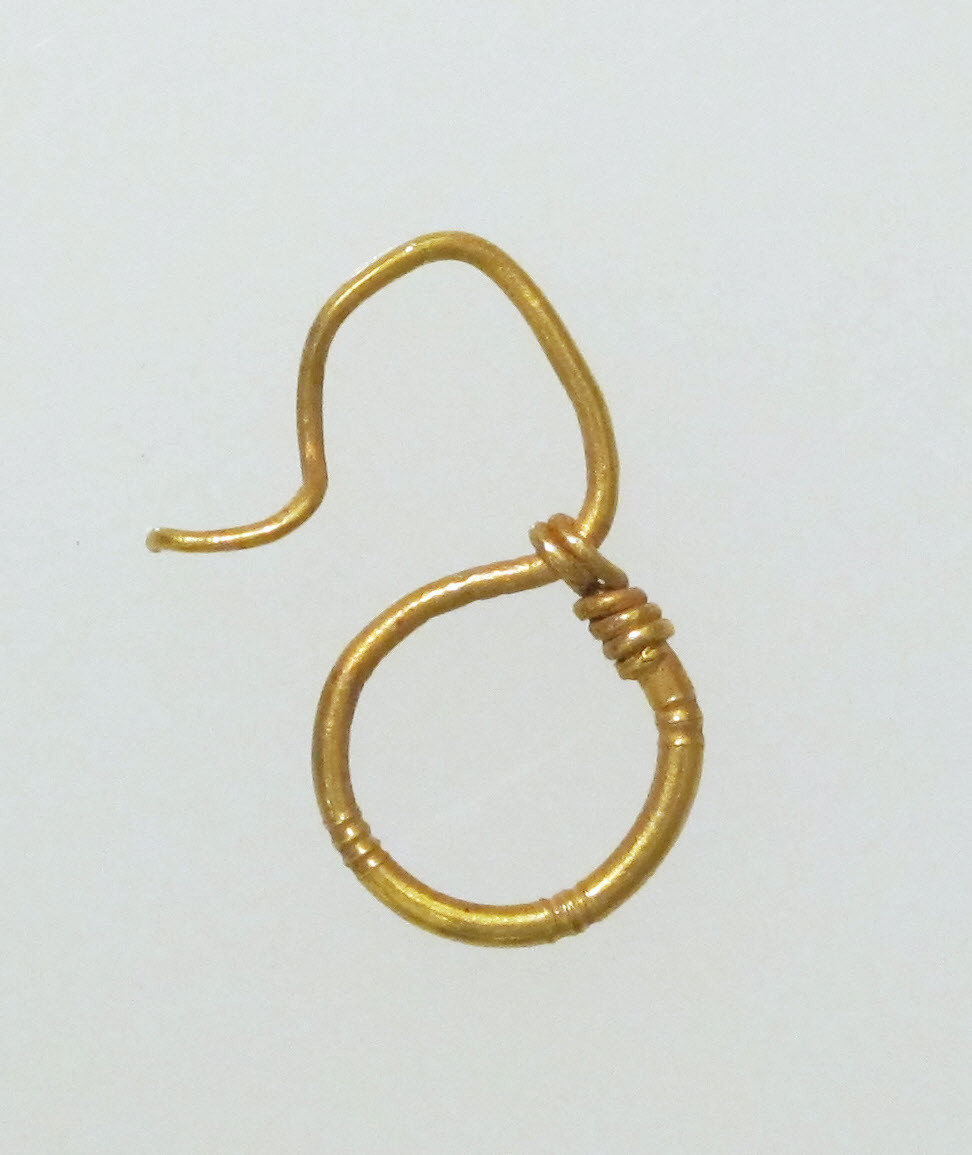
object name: earring, delta shaped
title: Earring, delta-shaped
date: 7000 BCE-330 CE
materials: gold